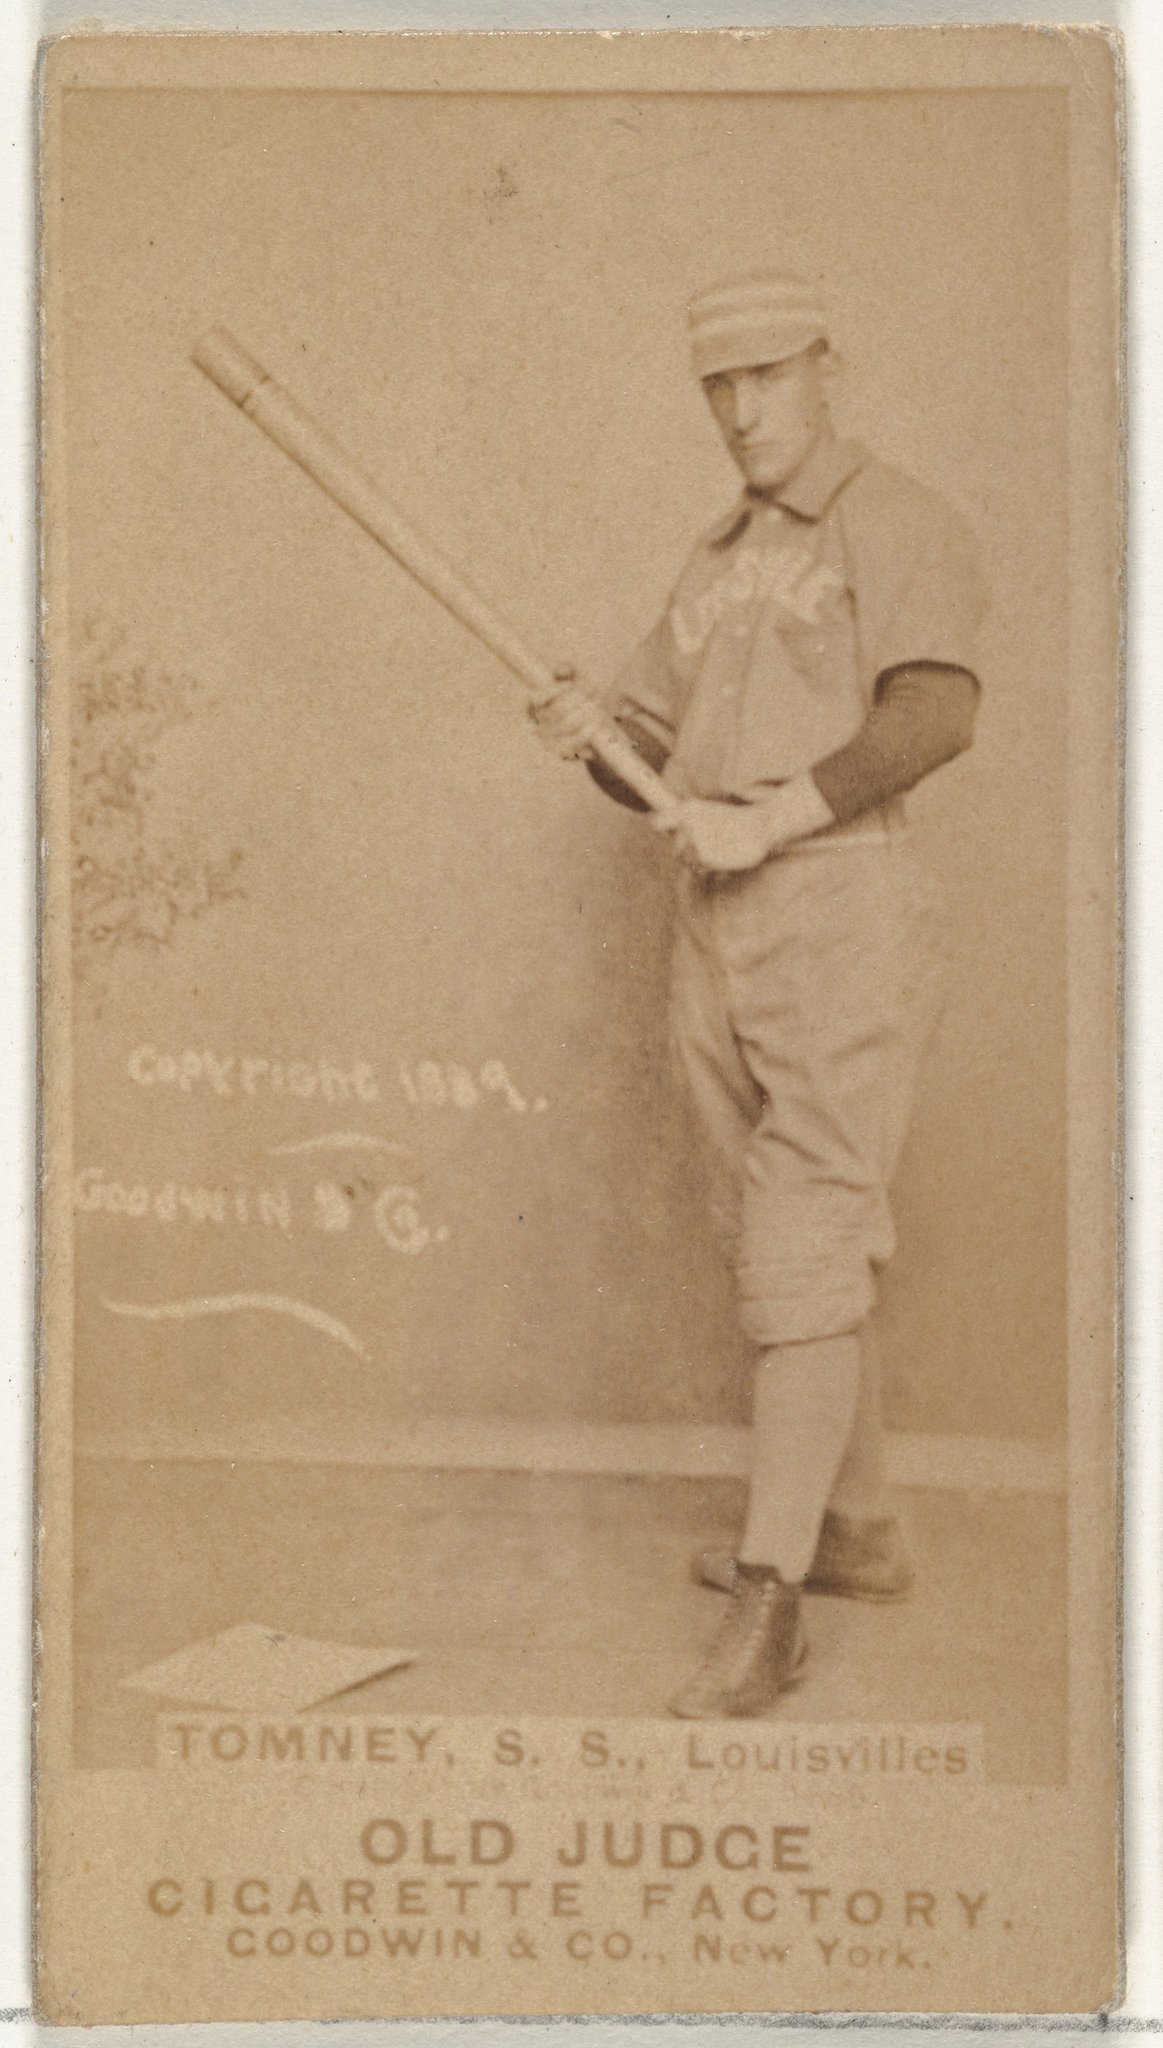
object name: baseball card, photograph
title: Philip H. "Buster" Tomney, Shortstop, Louisville Colonels, from the Old Judge series (N172) for Old Judge Cigarettes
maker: goodwin & company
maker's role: publisher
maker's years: 1850-1950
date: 1889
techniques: albumen silver print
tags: men,portraits,baseball,athletes